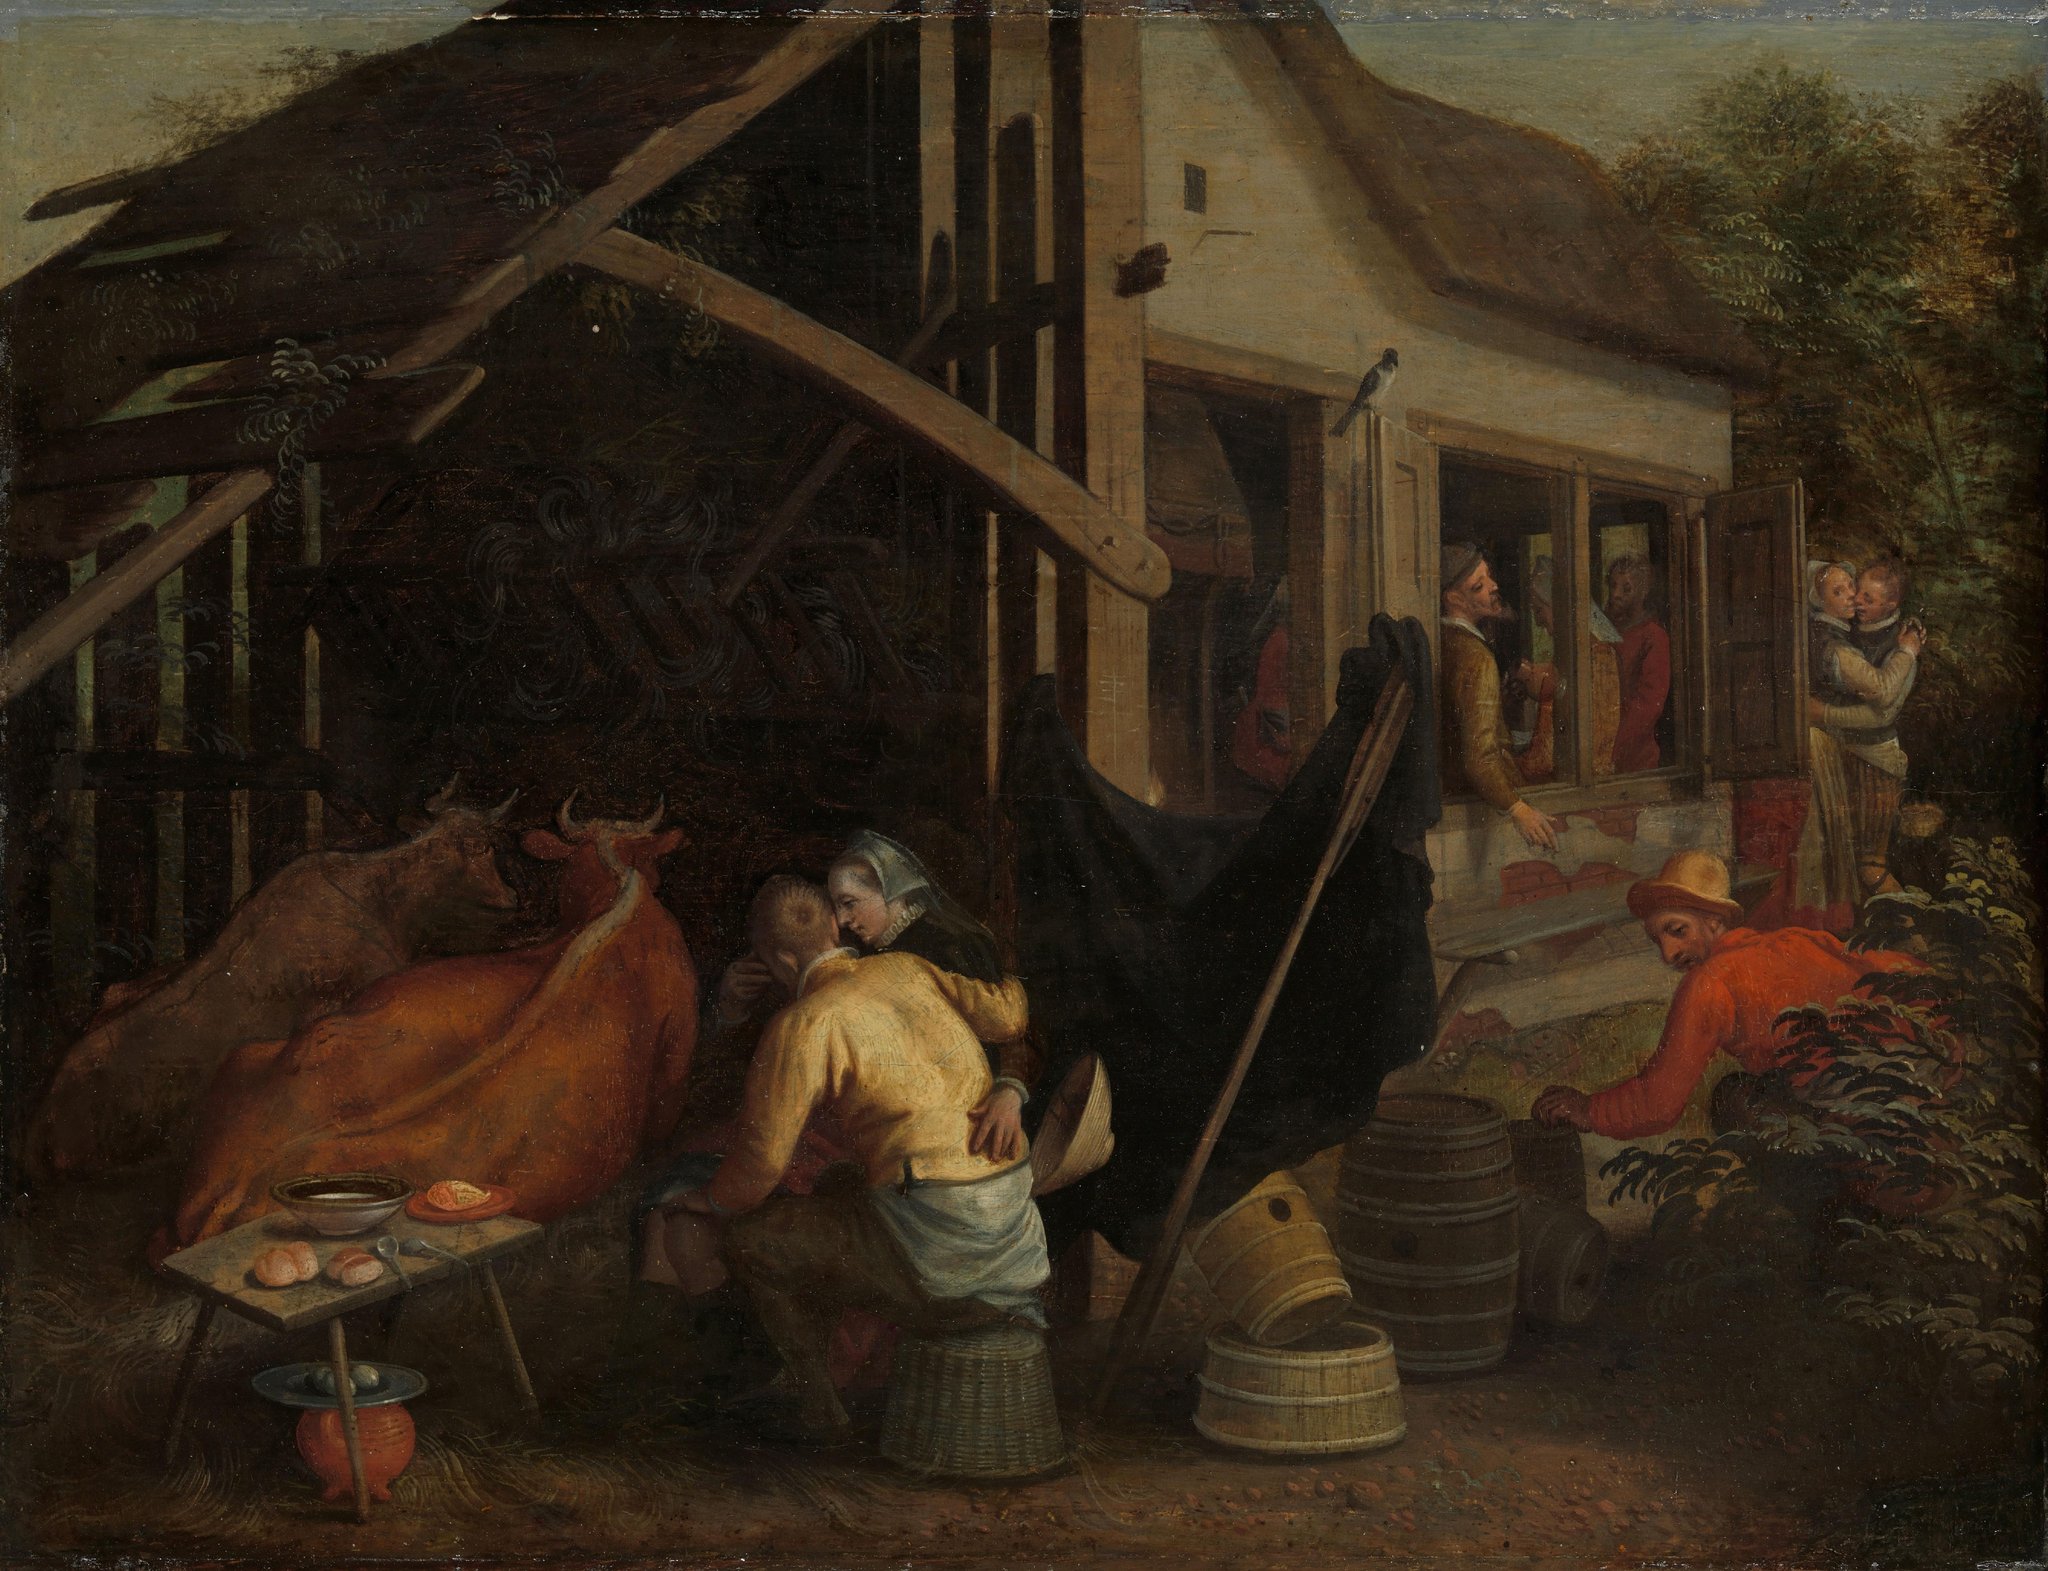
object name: painting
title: Couples Making Love at a Country Inn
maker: aert pietersz.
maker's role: draughtsman, painter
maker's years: 1550-1612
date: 1570-1590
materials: oil, panel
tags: (lovers) kissing each other, inn, coffee-house, public house, etc., farm (building)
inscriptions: signature, under at the left on the bench: ‘AP’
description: Twee minnende paren bij een herberg. Links zit een liefdespaar achter een doek bij de koestal, op een tafeltje liggen broodjes, lepels en een kom. Rechts achter een openstaande luik omhelzen een kussende man en vrouw elkaar. In het midden hurkt een poepende man tussen de struiken. Door de ramen van de herberg zijn andere gasten te zien.